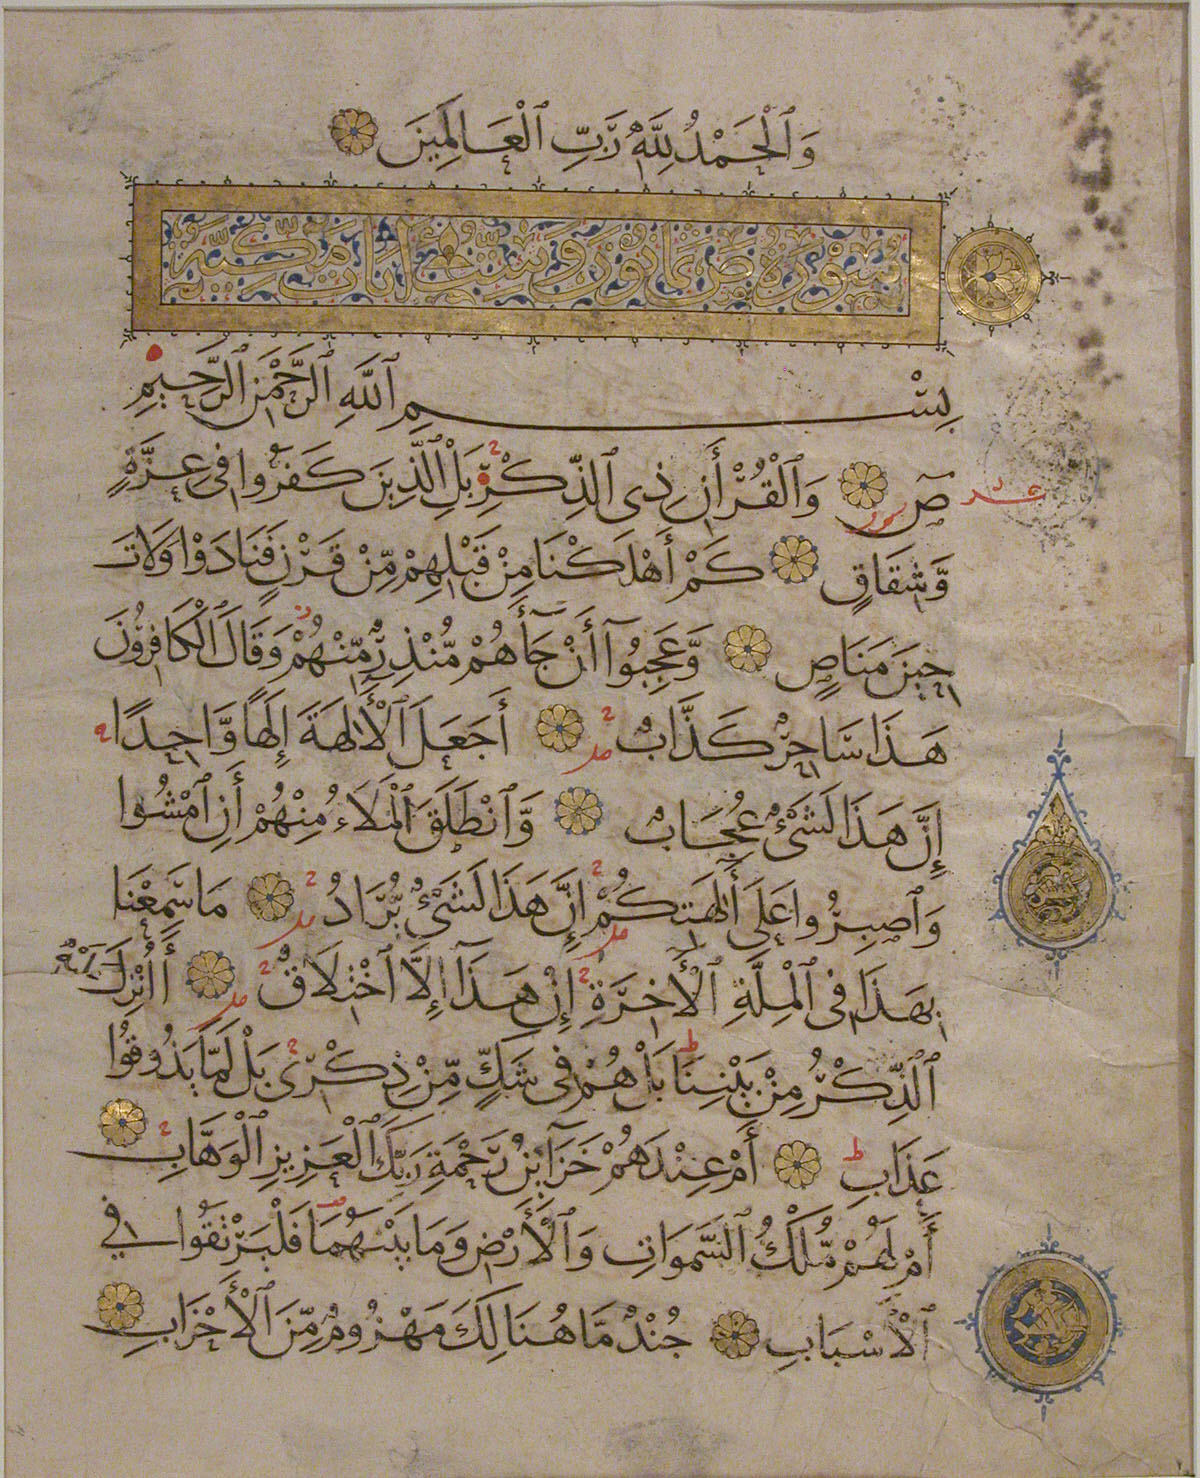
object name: folio from a non illustrated manuscript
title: Folio from a Qur'an Manuscript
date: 1301-1333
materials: gold, ink, paper, watercolor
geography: iran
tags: qur'an,calligraphy